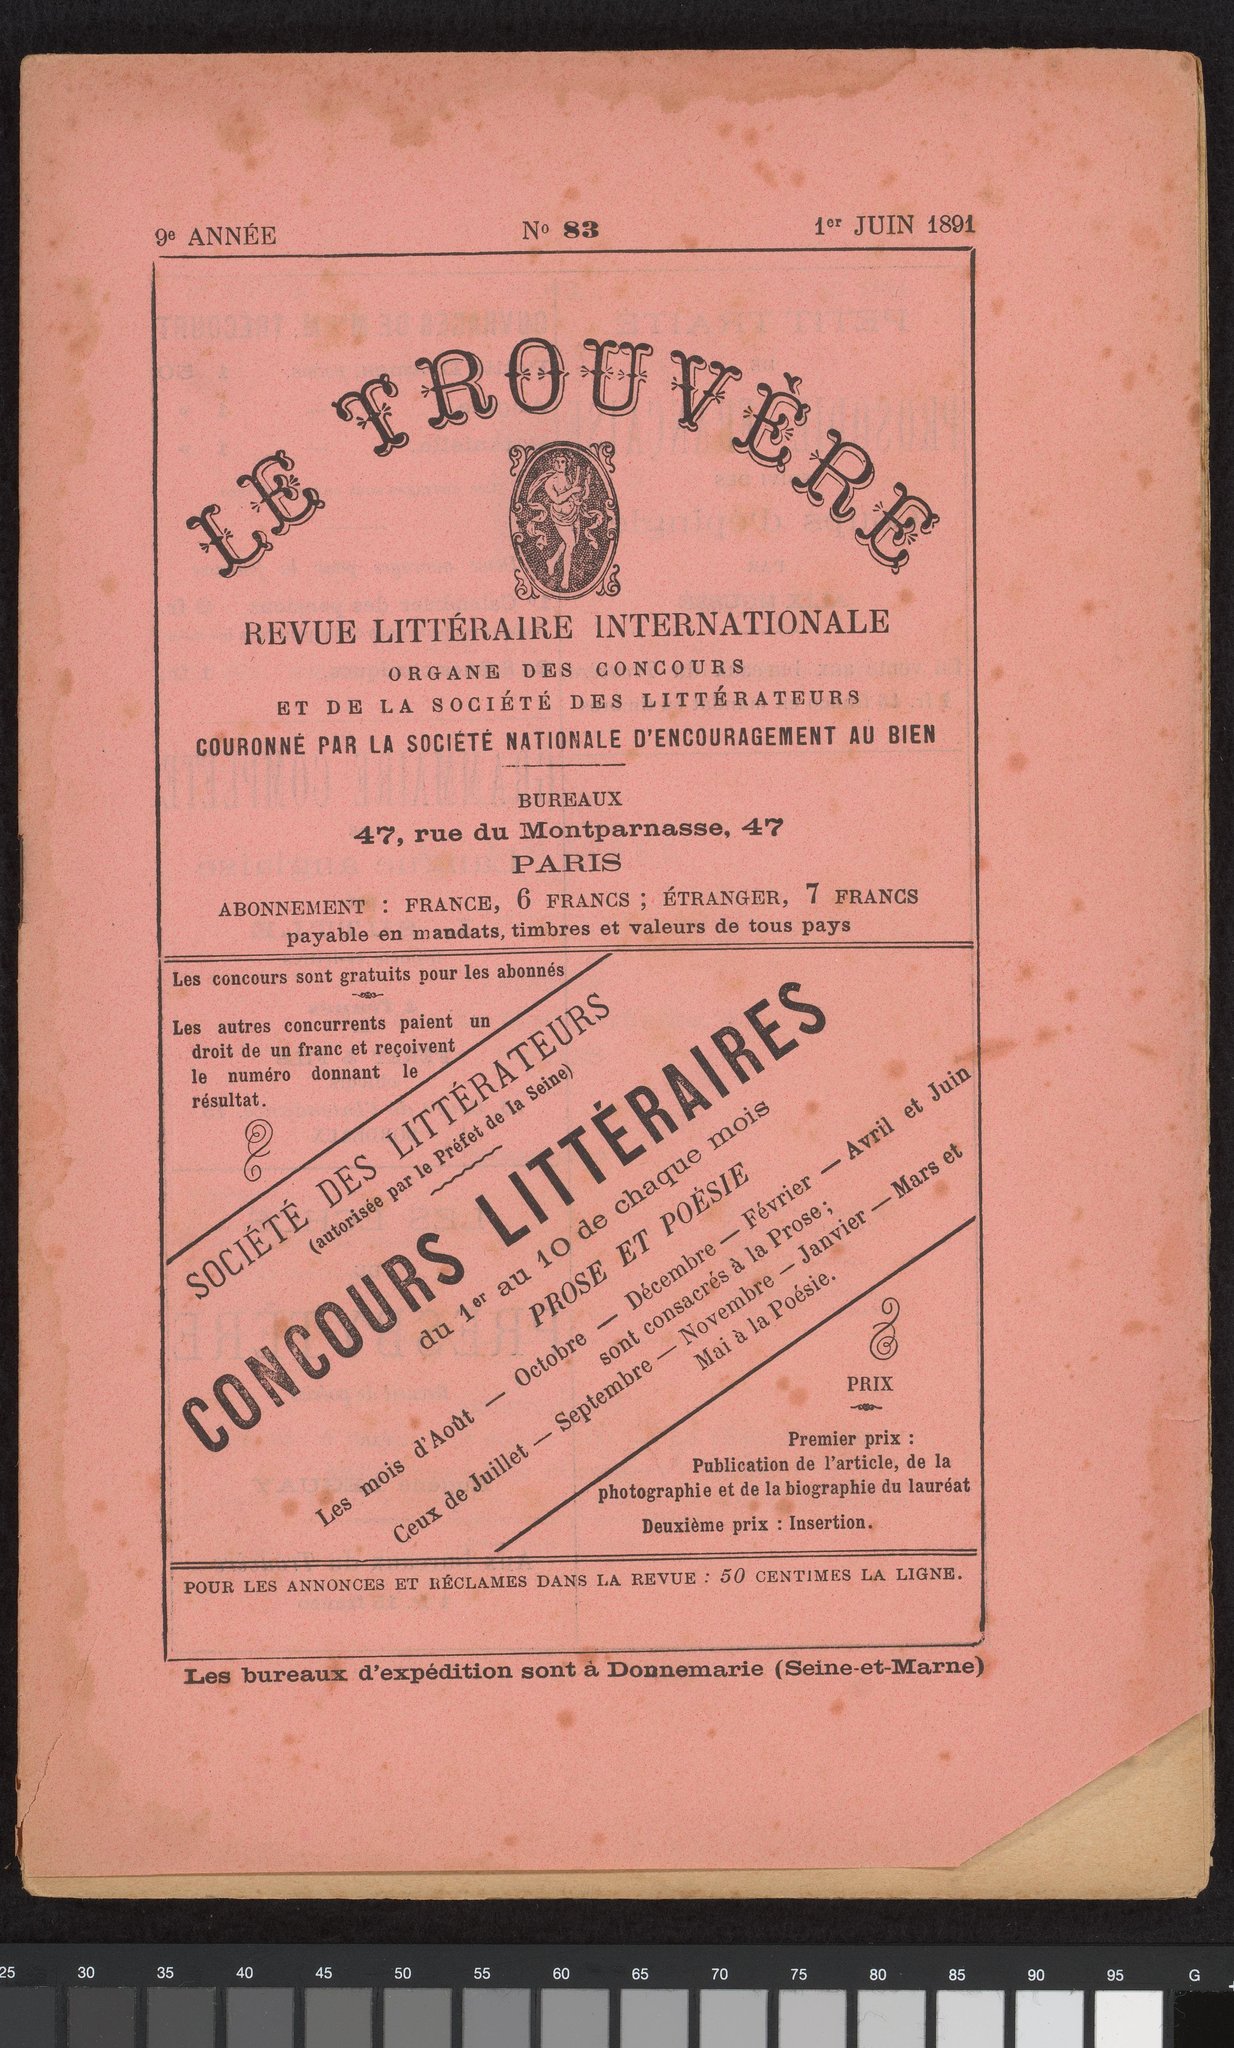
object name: book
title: Le trouvère No 83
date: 1806-1891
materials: paper, photographic support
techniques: albumen print, printing, engraving